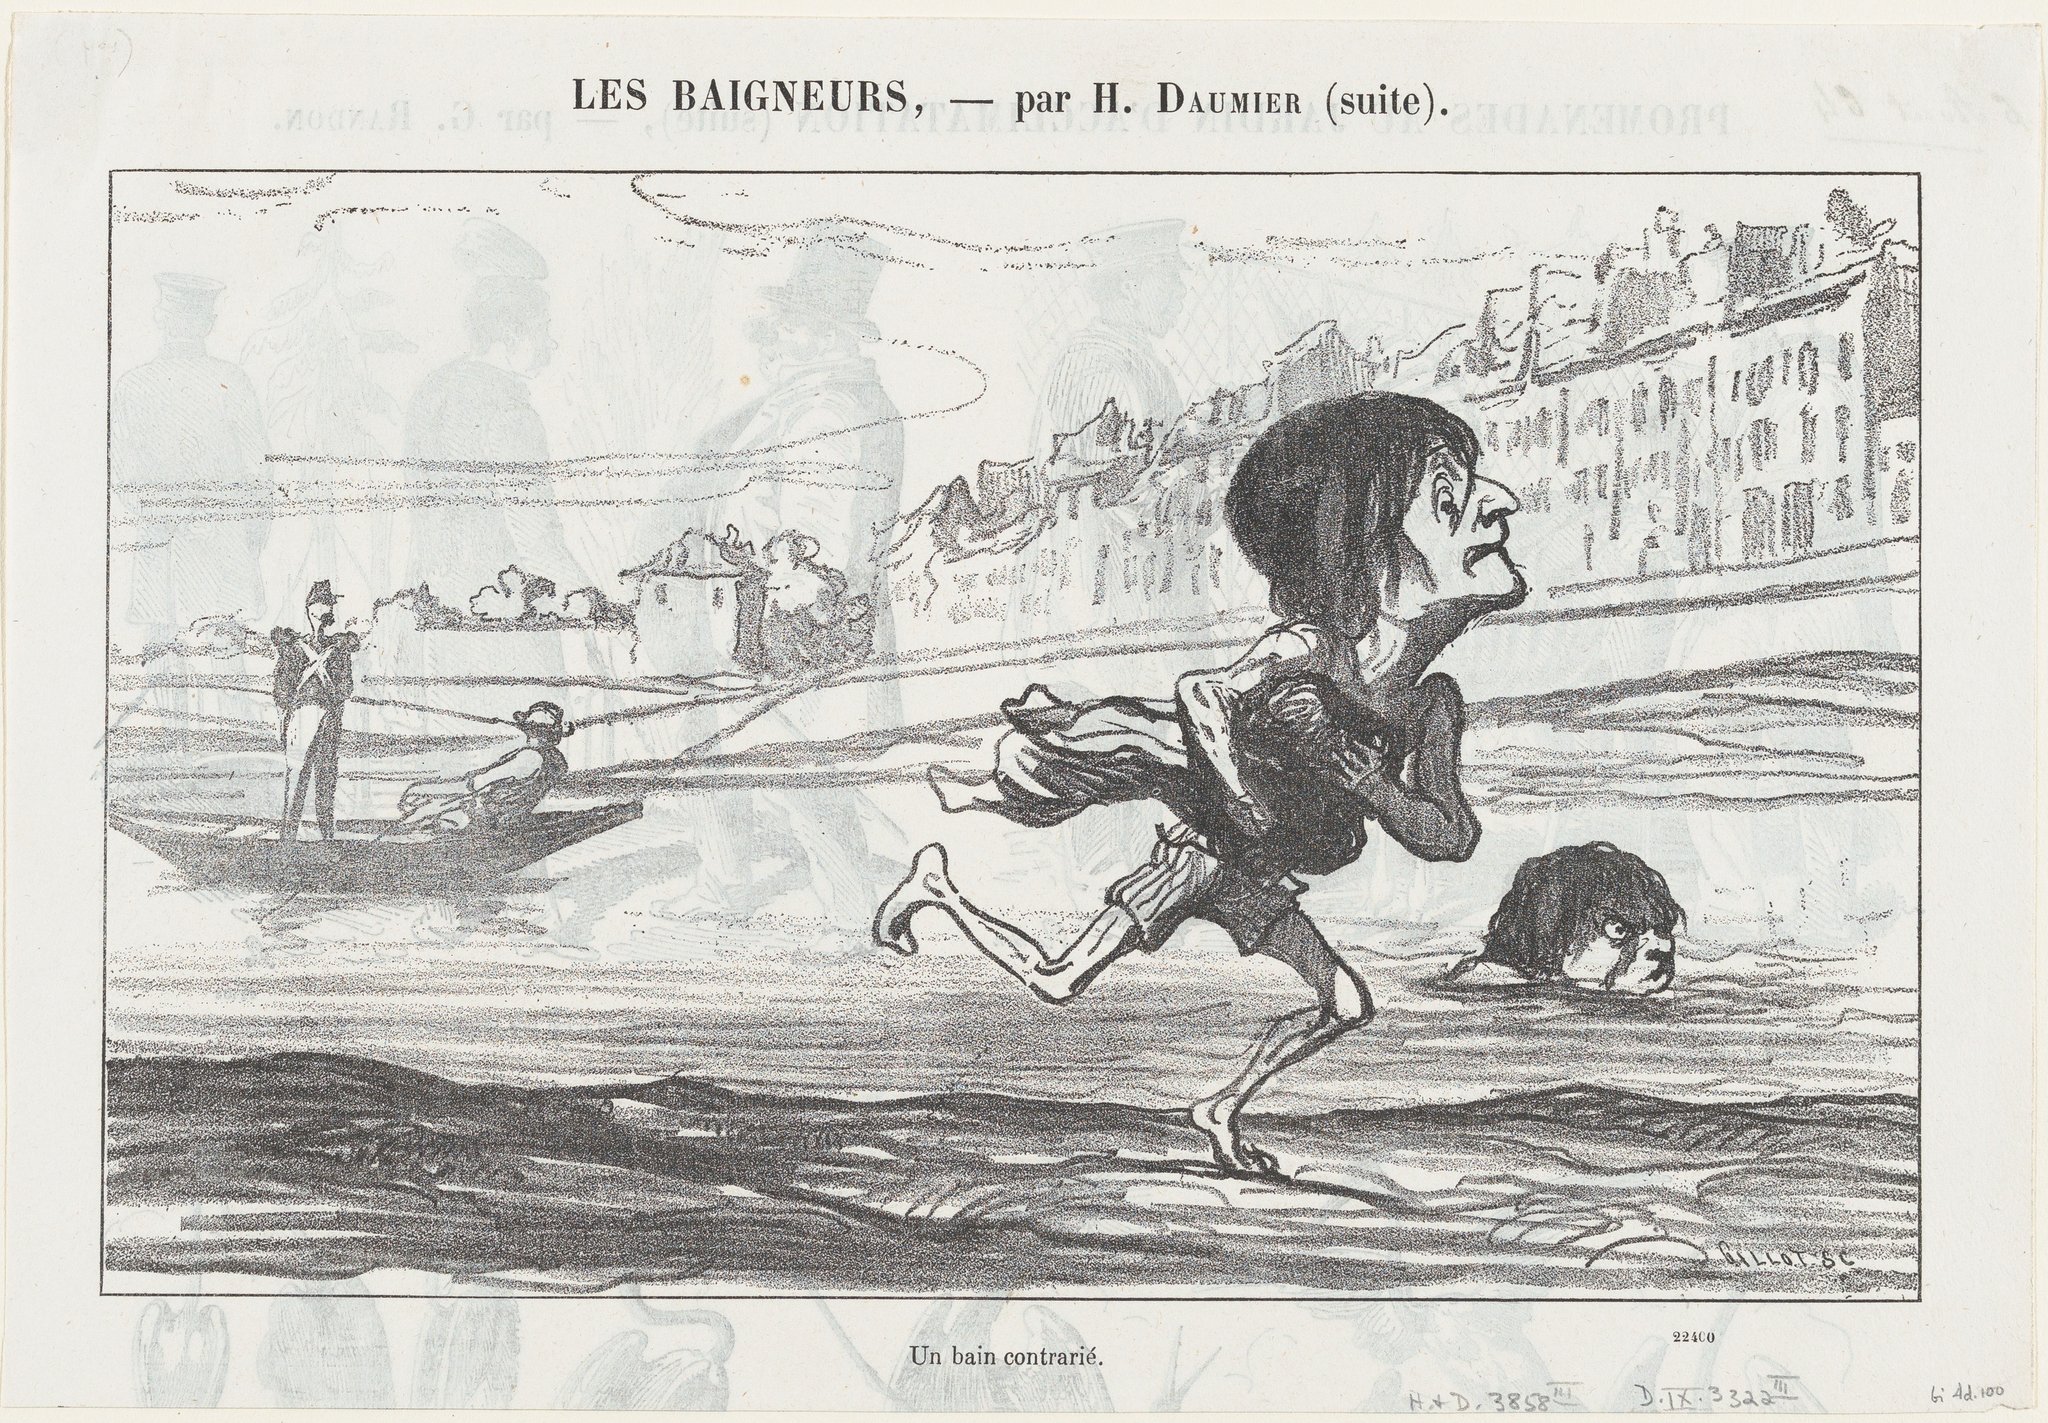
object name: print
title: A forbidden swimming pleasure, from 'The bathers,' published in Le Petit Journal pour Rire, August 6, 1864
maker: honoré daumier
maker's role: artist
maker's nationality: french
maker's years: 1808-1879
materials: paper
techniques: lithograph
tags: satire,men,bathing